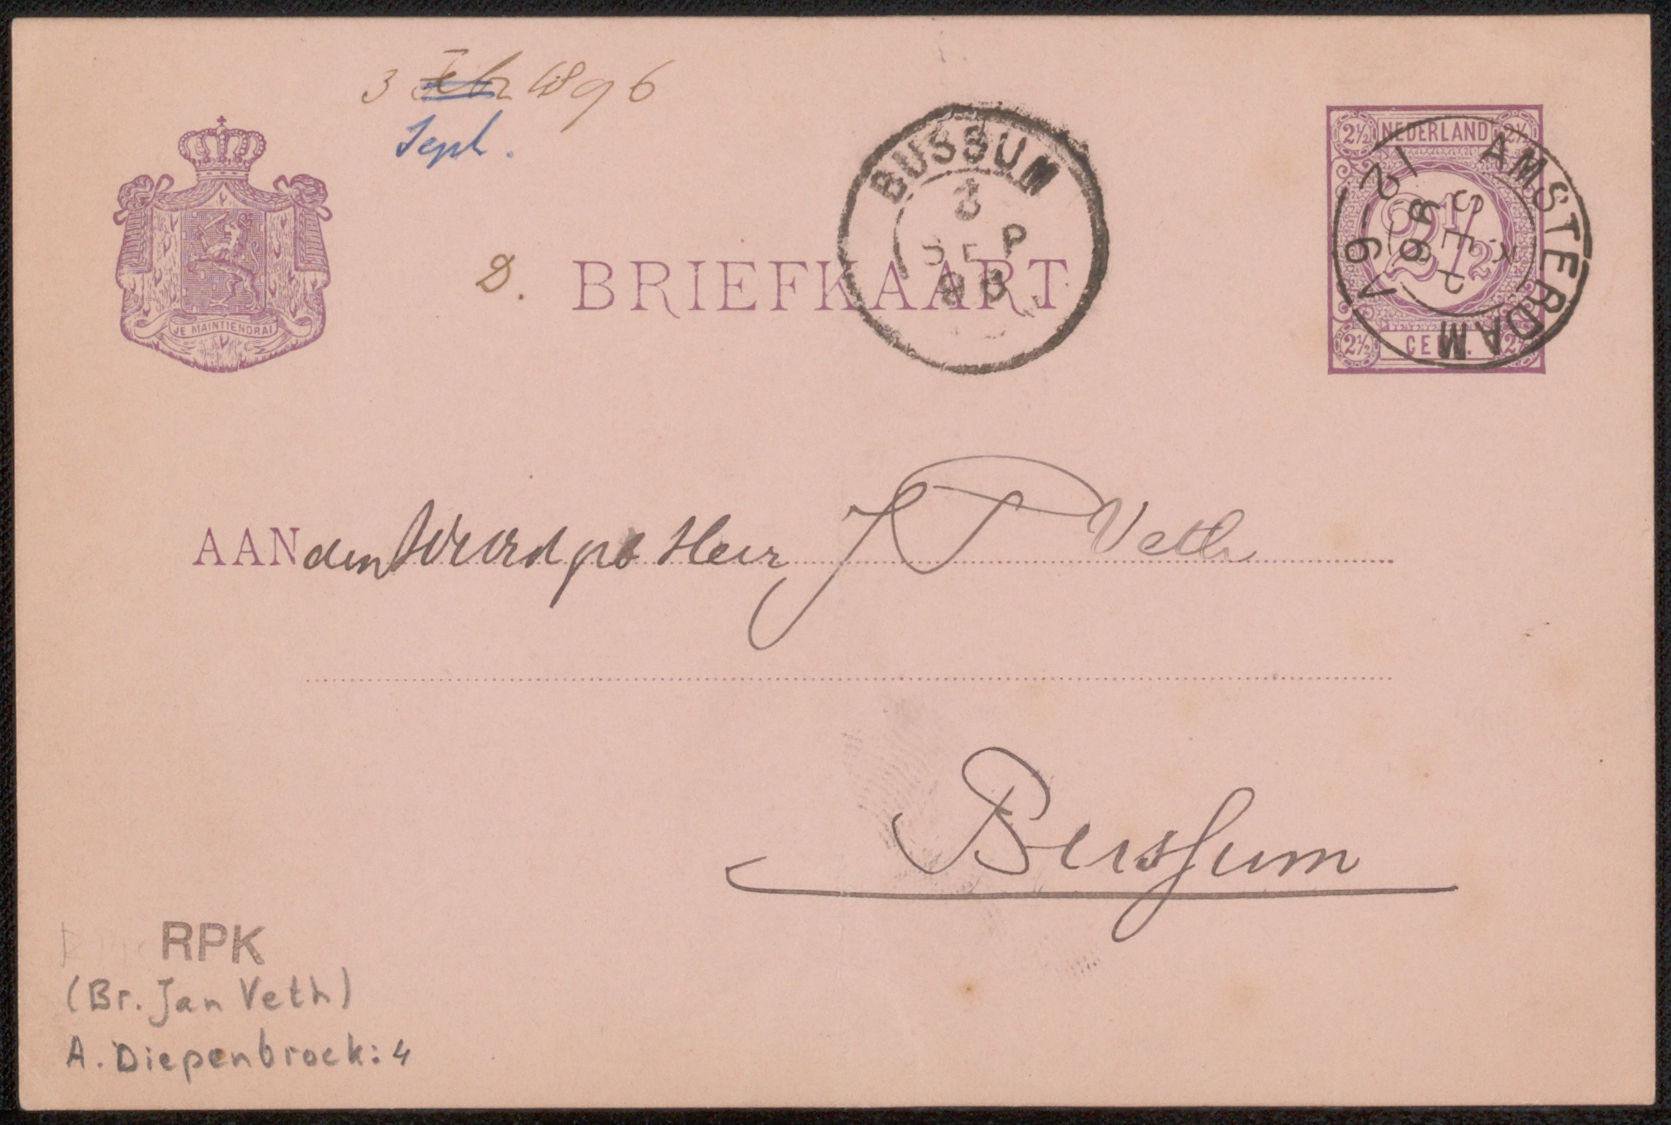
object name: postcard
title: Briefkaart aan Jan Veth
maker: alphons diepenbrock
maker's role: componist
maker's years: 1862-1921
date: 1896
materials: cardboard, ink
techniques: pen, writing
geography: amsterdam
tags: dordrecht, amsterdam, painter, print maker, draughtsman, designer, jan veth, middelburg, politician, pieter lodewijk tak, printed matter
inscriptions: collector's mark: ‘RPK’